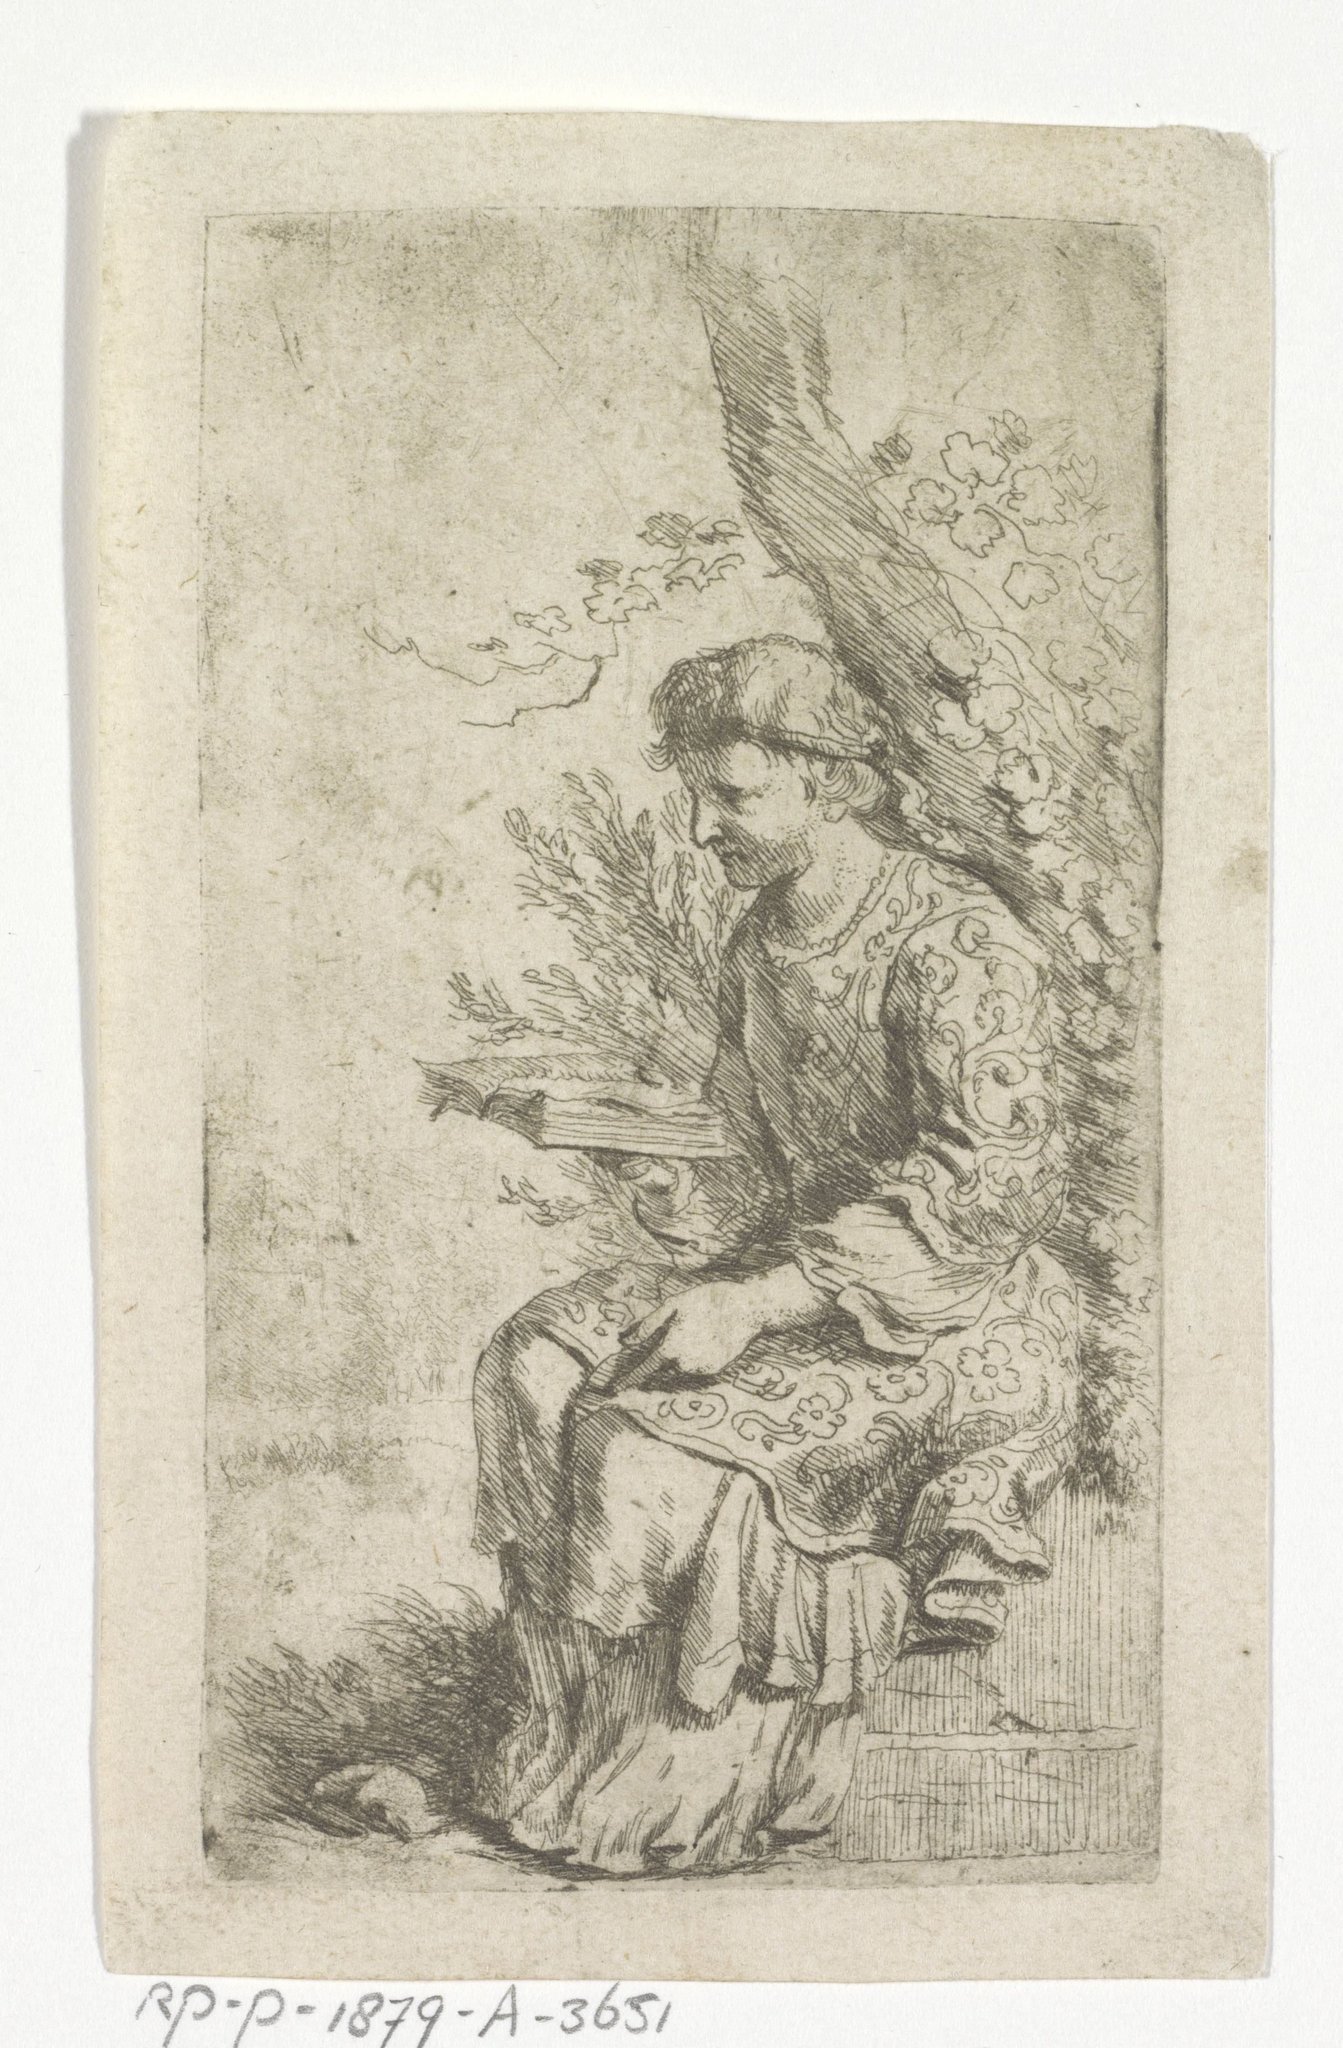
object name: print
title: Vrouw met opengeslagen boek onder een boom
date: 1650-1700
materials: paper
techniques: etching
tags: reading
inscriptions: collector's mark: Lugt 2228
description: Een vrouw zit met een opengeslagen boek in haar hand onder een boom te lezen.